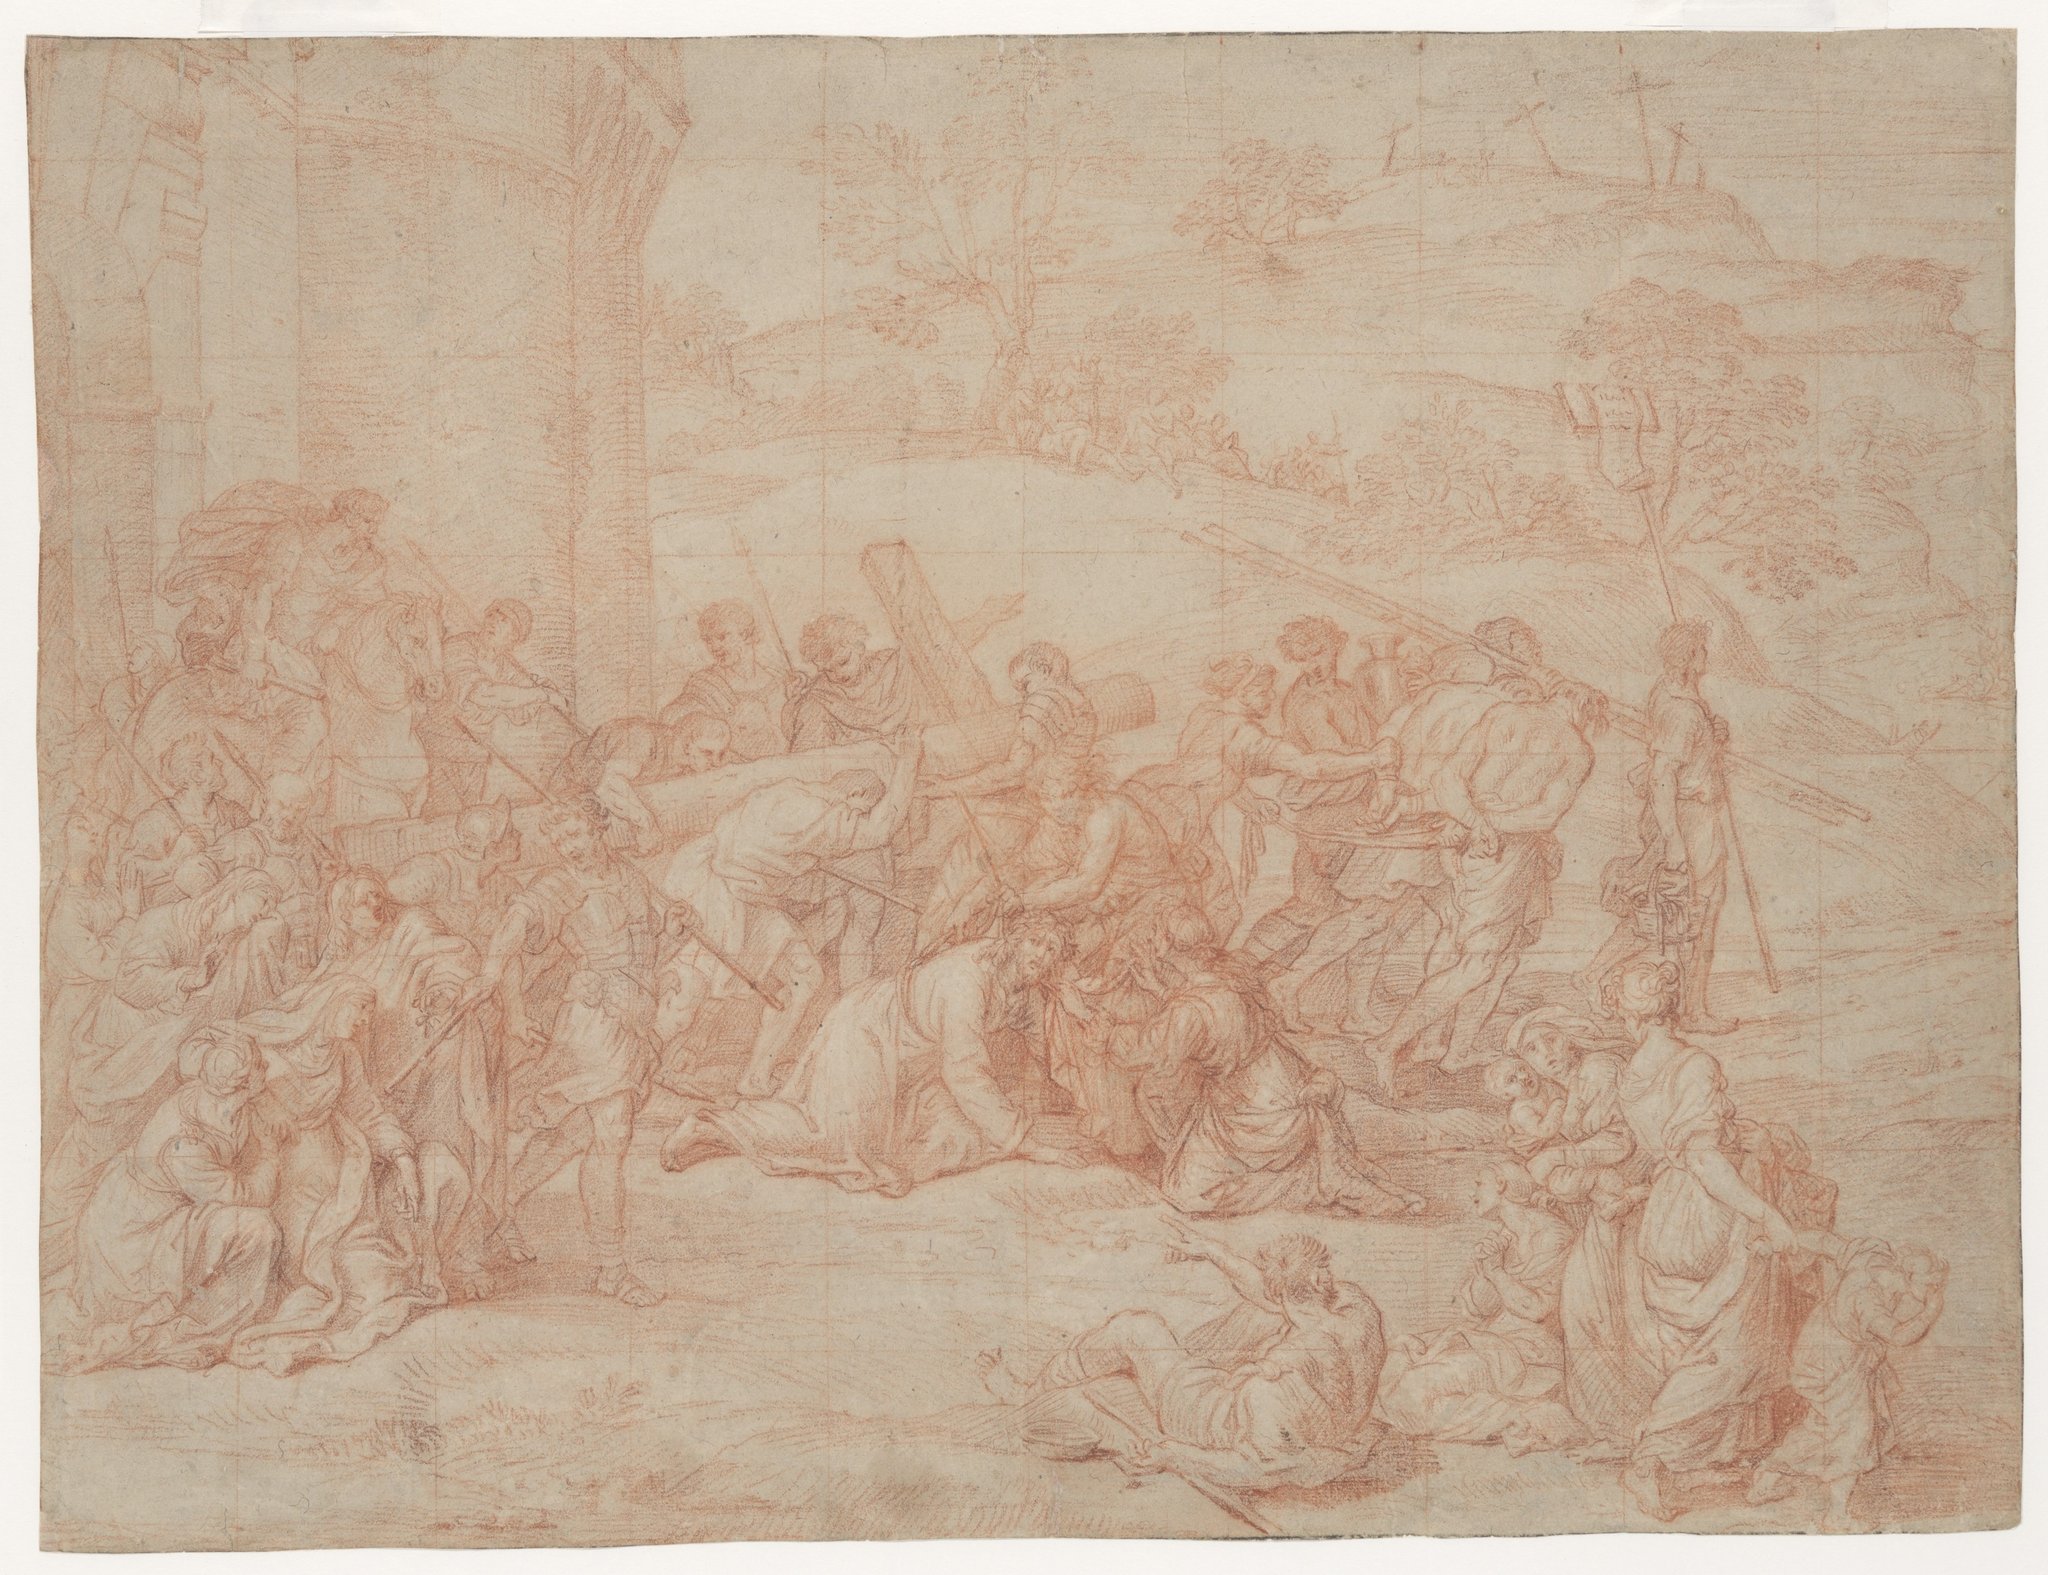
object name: drawing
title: Christ Carrying the Cross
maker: pierre mignard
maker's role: artist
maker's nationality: french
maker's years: 1612-1695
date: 1684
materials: chalk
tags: infants,men,women,christ,cross